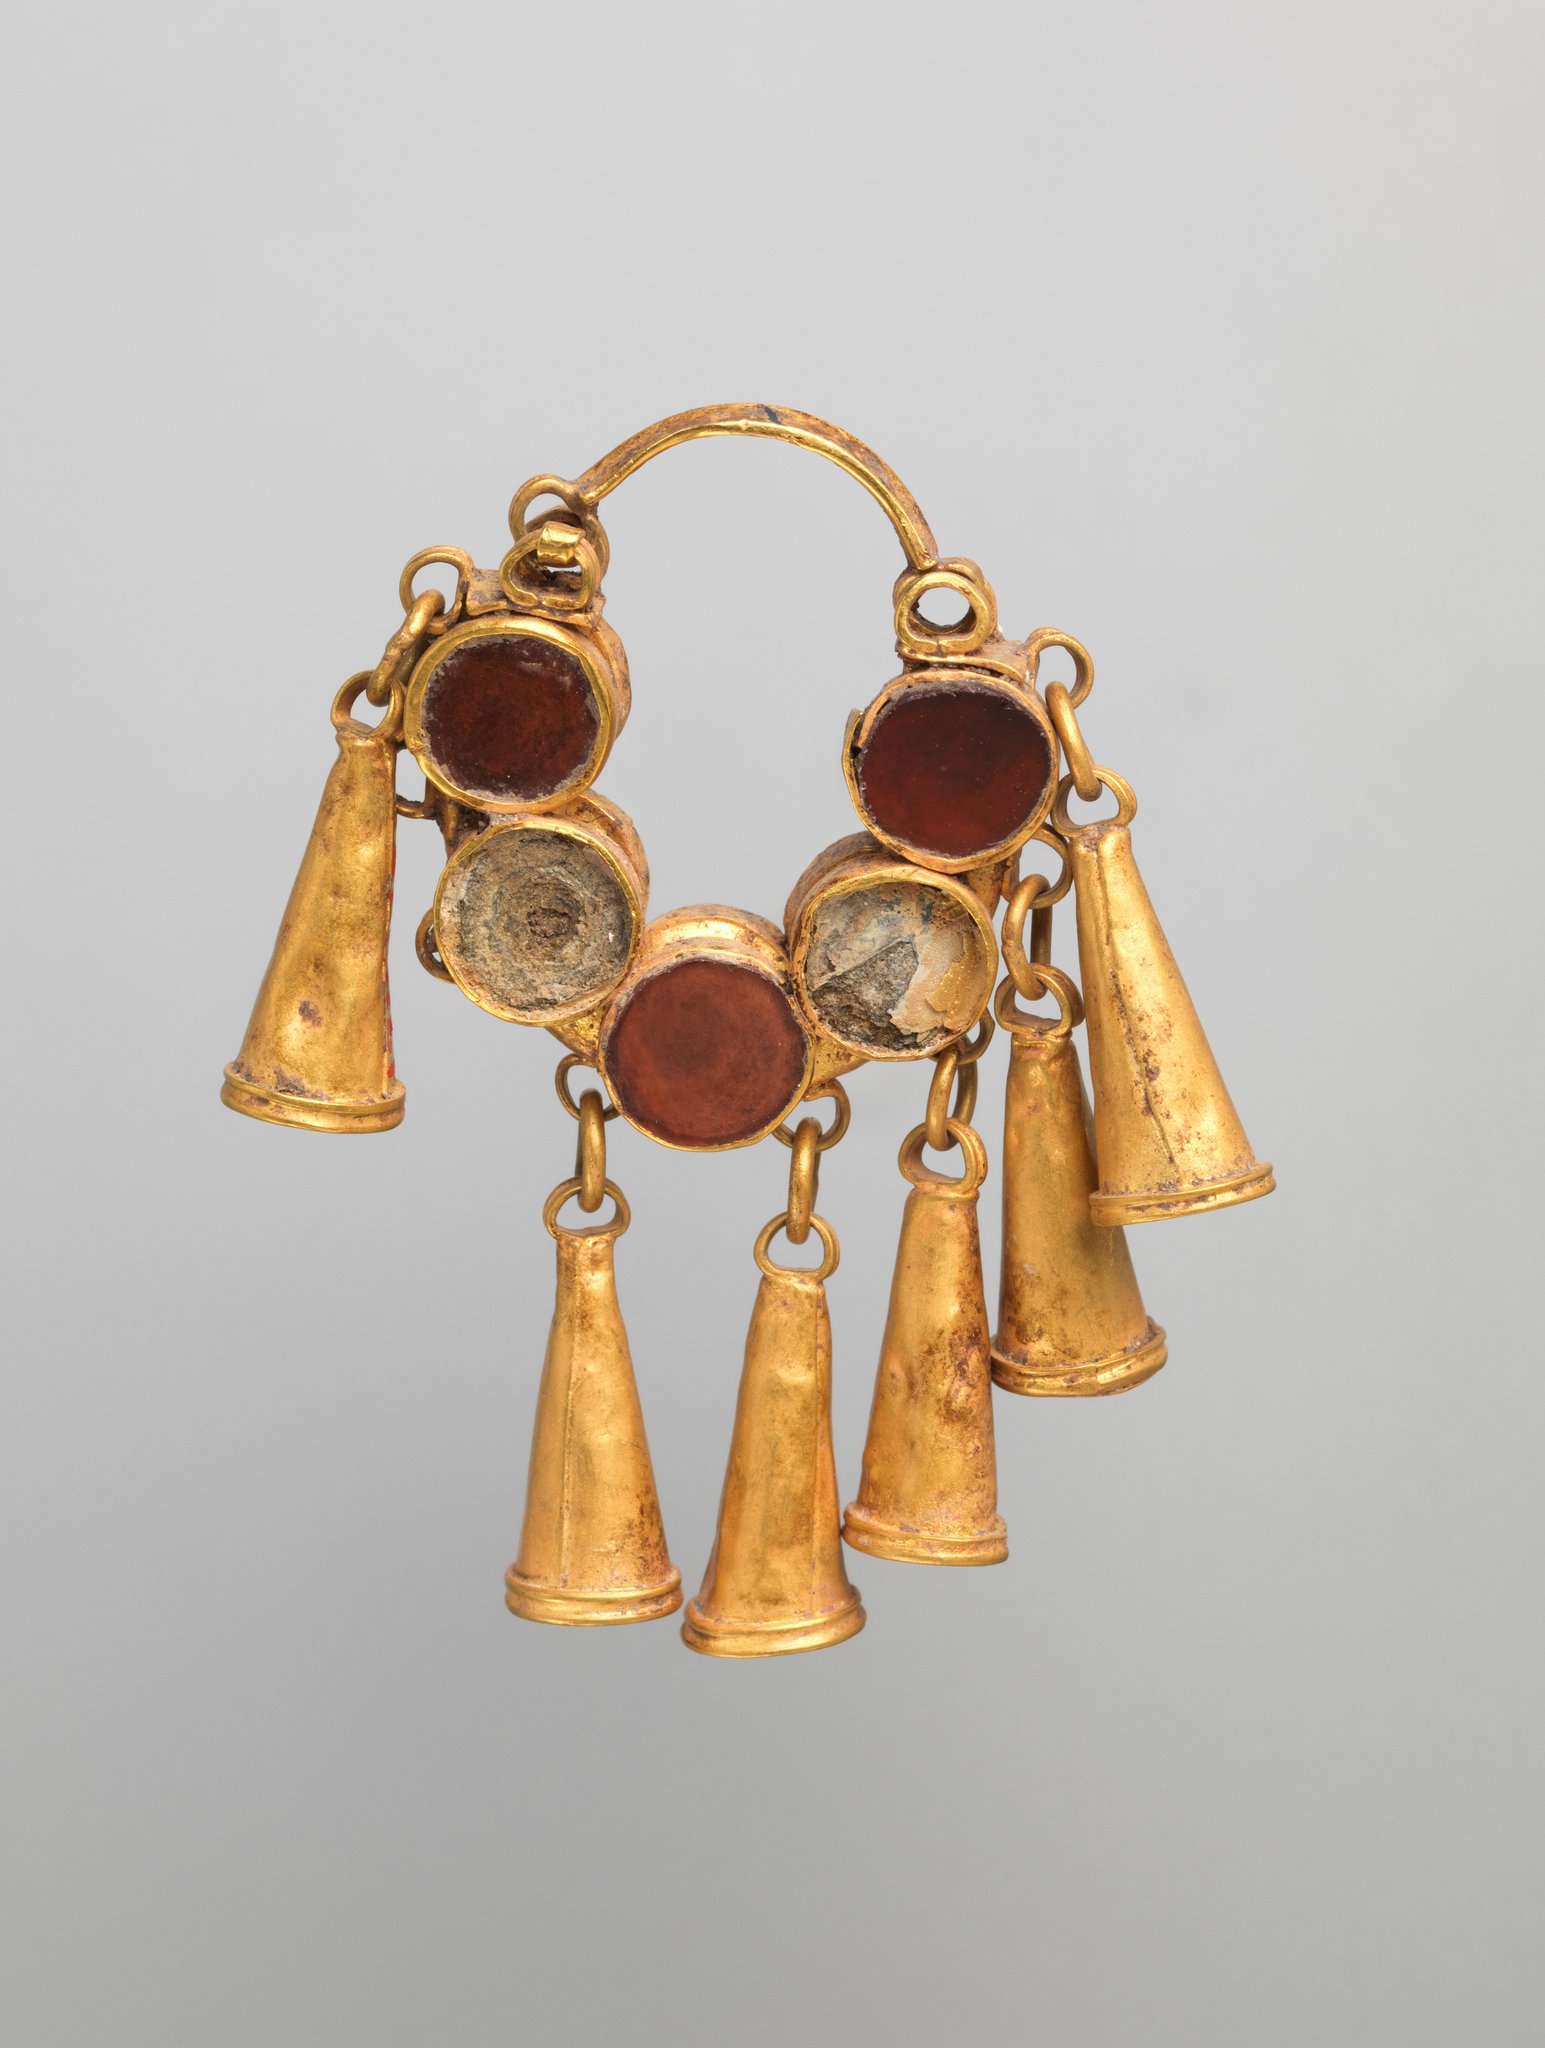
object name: earring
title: Earrings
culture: parthian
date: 1-200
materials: gemstone, gold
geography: mesopotamia or iran